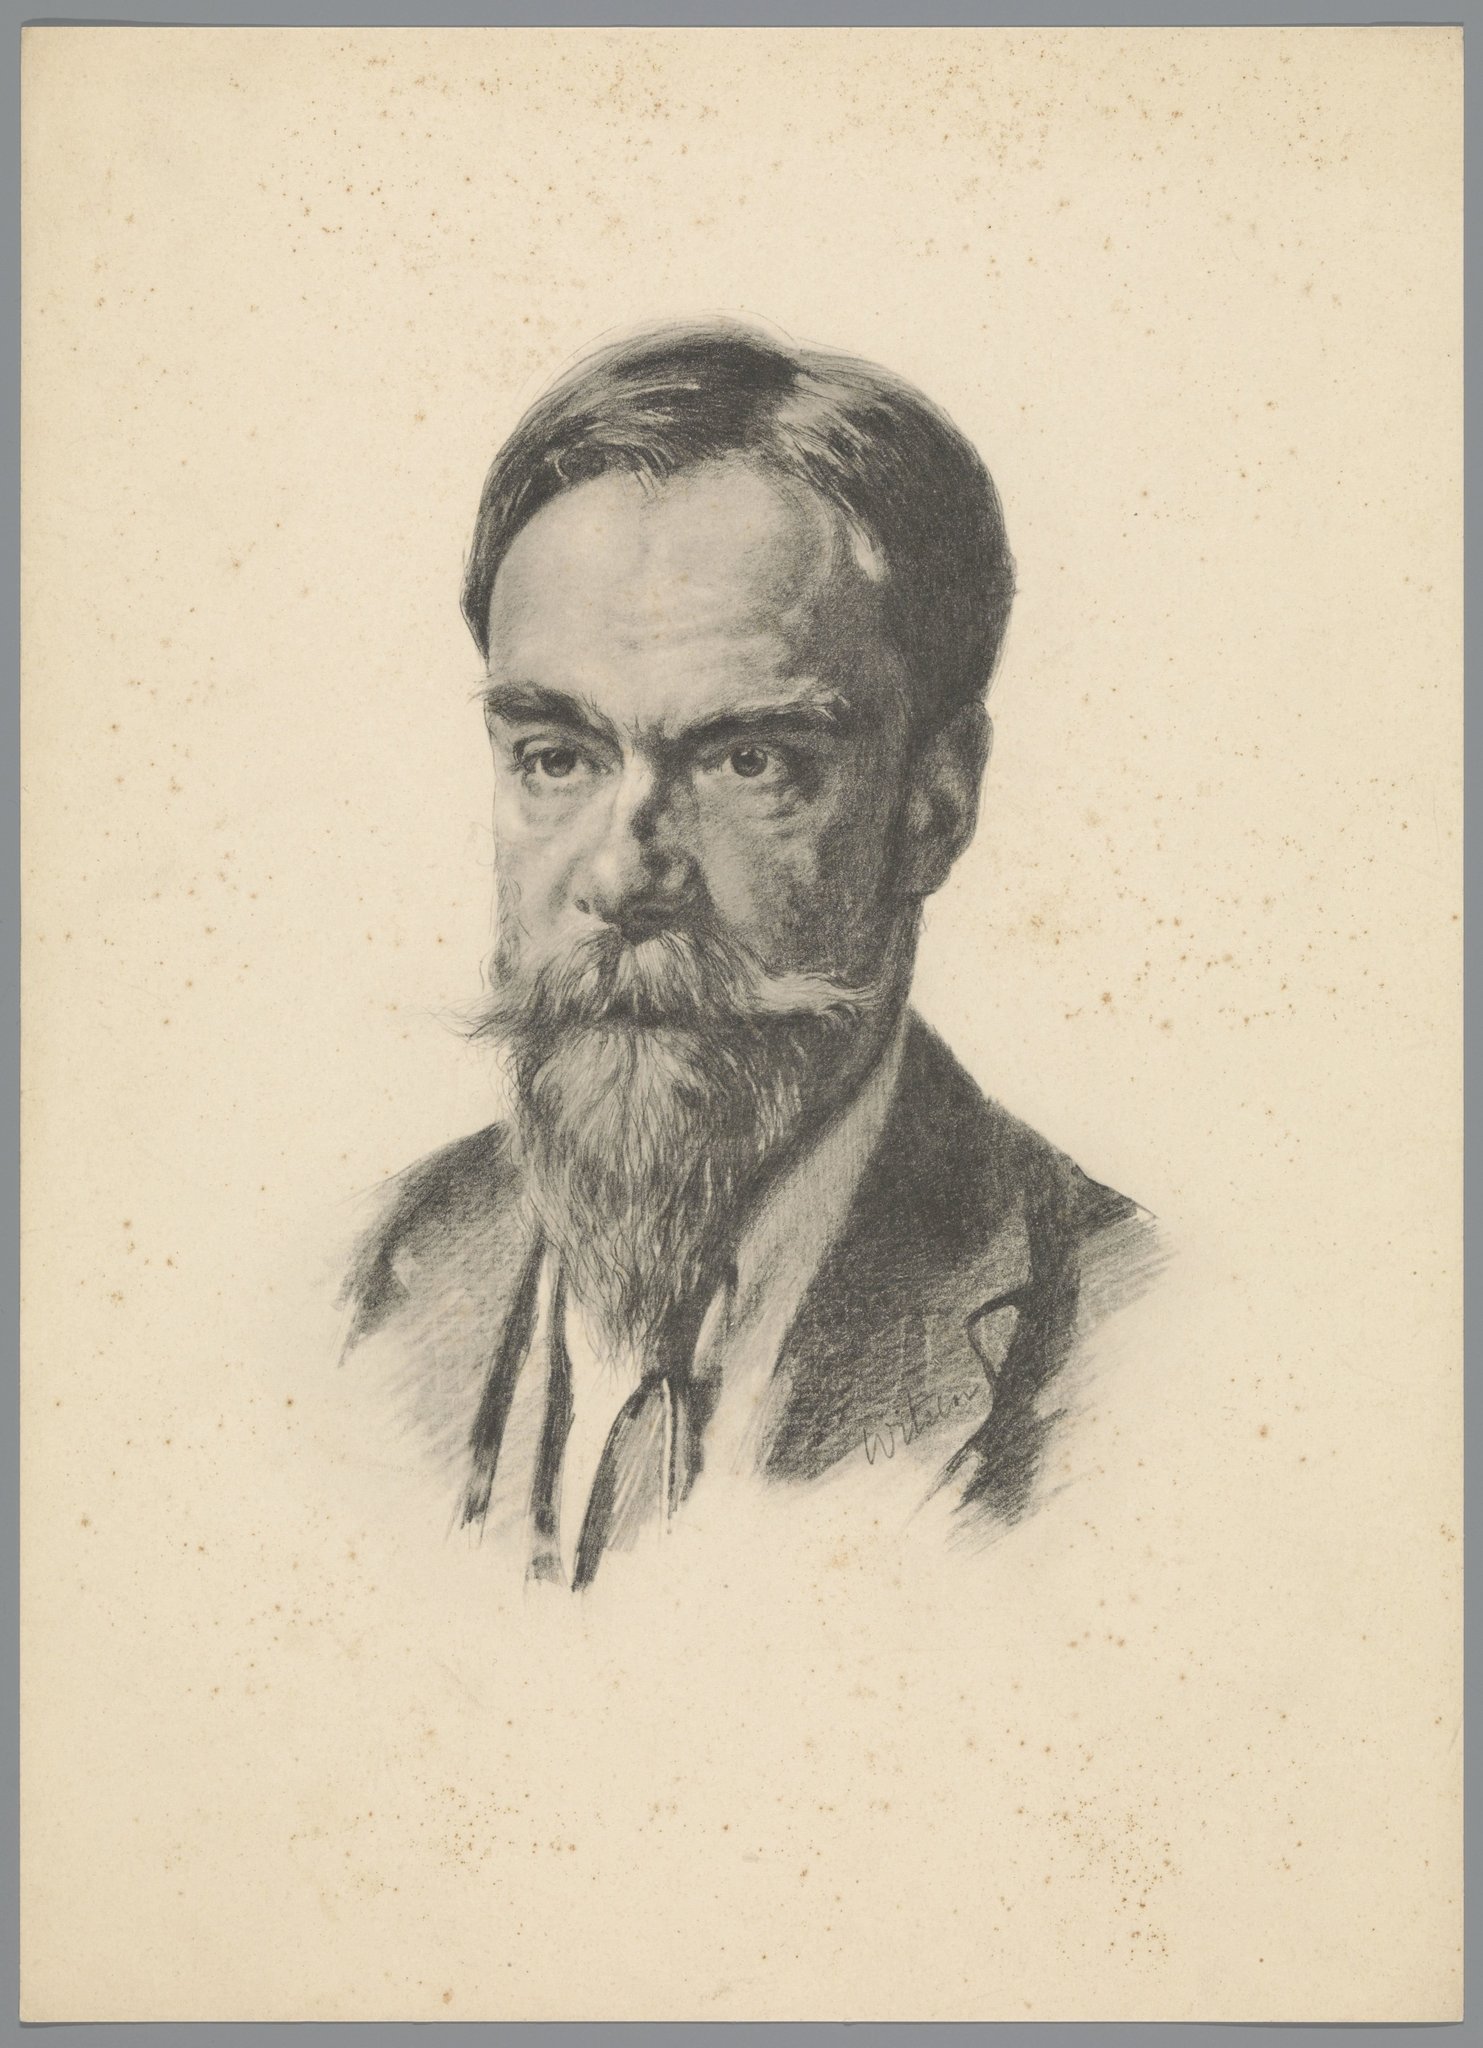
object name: print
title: Reproductie naar krijttekening met portret van Frans Coenen Jr.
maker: Anonymous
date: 1860-1915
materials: paper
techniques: photograph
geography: netherlands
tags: frans coenen (1866-1936)